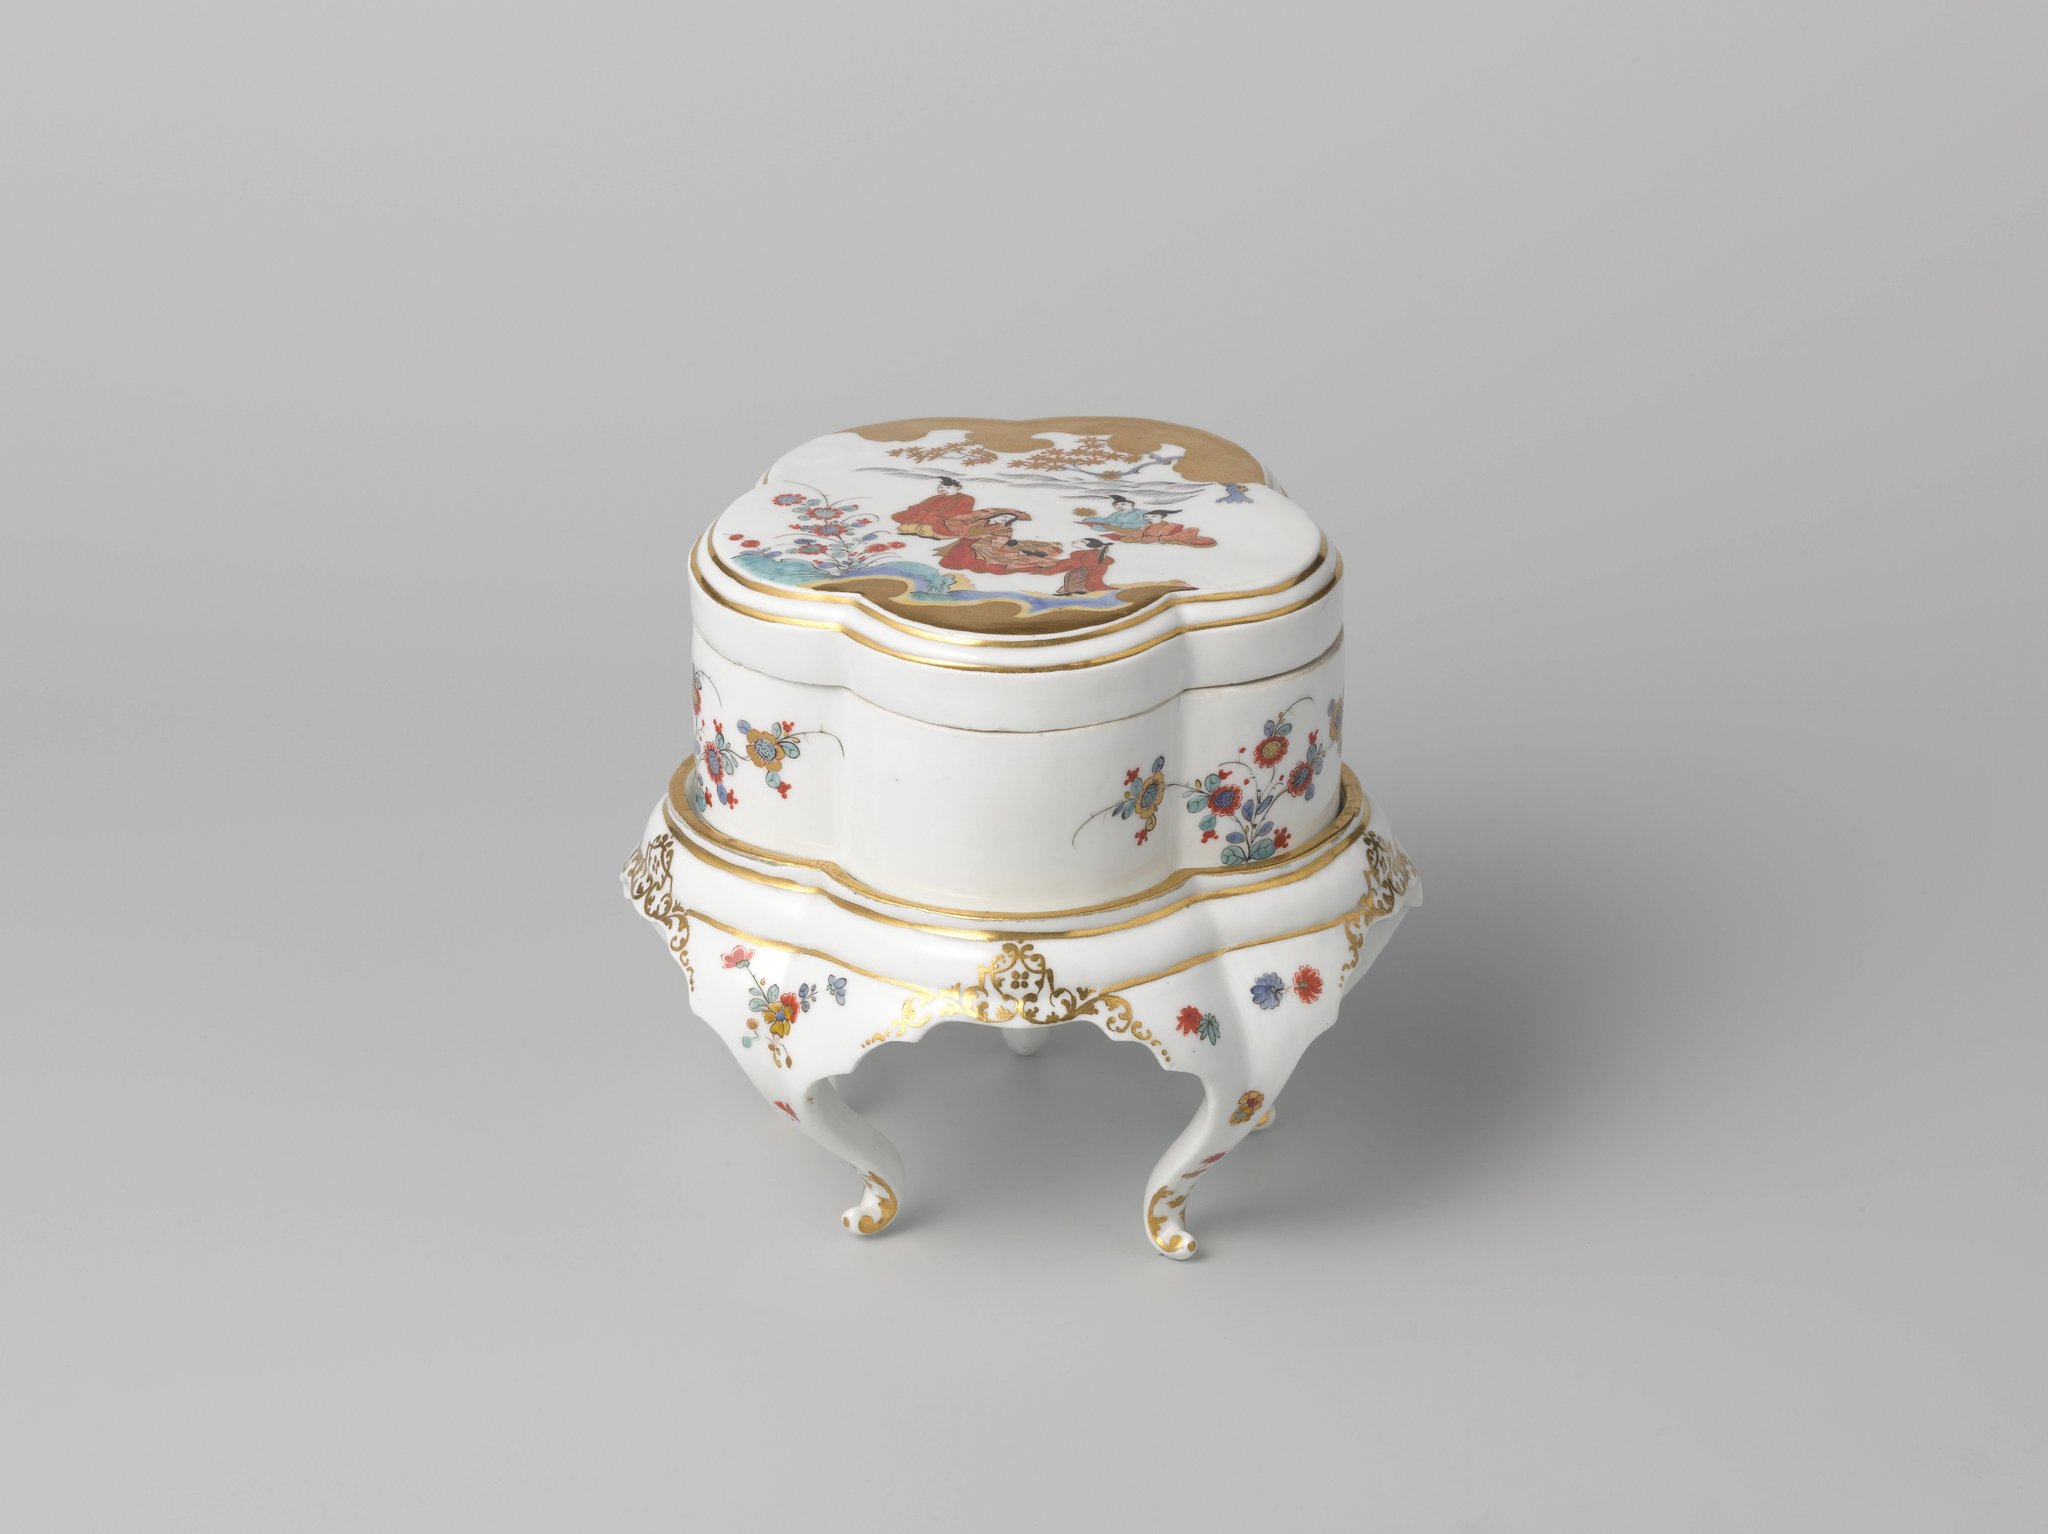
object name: dressing case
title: Toilet Box on Stand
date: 1730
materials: porcelain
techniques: painted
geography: meissen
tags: flowers ~ ornament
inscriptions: number: ‘103.’, number: ‘103.’, number: ‘[...] R [...] / [...] T 1353’, mark, factory mark, mold mark: ‘een kruis in een cirkel viermaal (Rückert 1996, afb. 9, nr. 7)’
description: The delicate shape of this toilet box on a stand is inspired by lacquerware boxes from Japan. The decorations too are copies of scenes often depicted in Japanese lacquerware and porcelain. In 1927, when their collection was catalogued, Margarethe and Franz Oppenheimer owned the box but not the stand. A few years later, they succeeded in bringing together the two pieces.